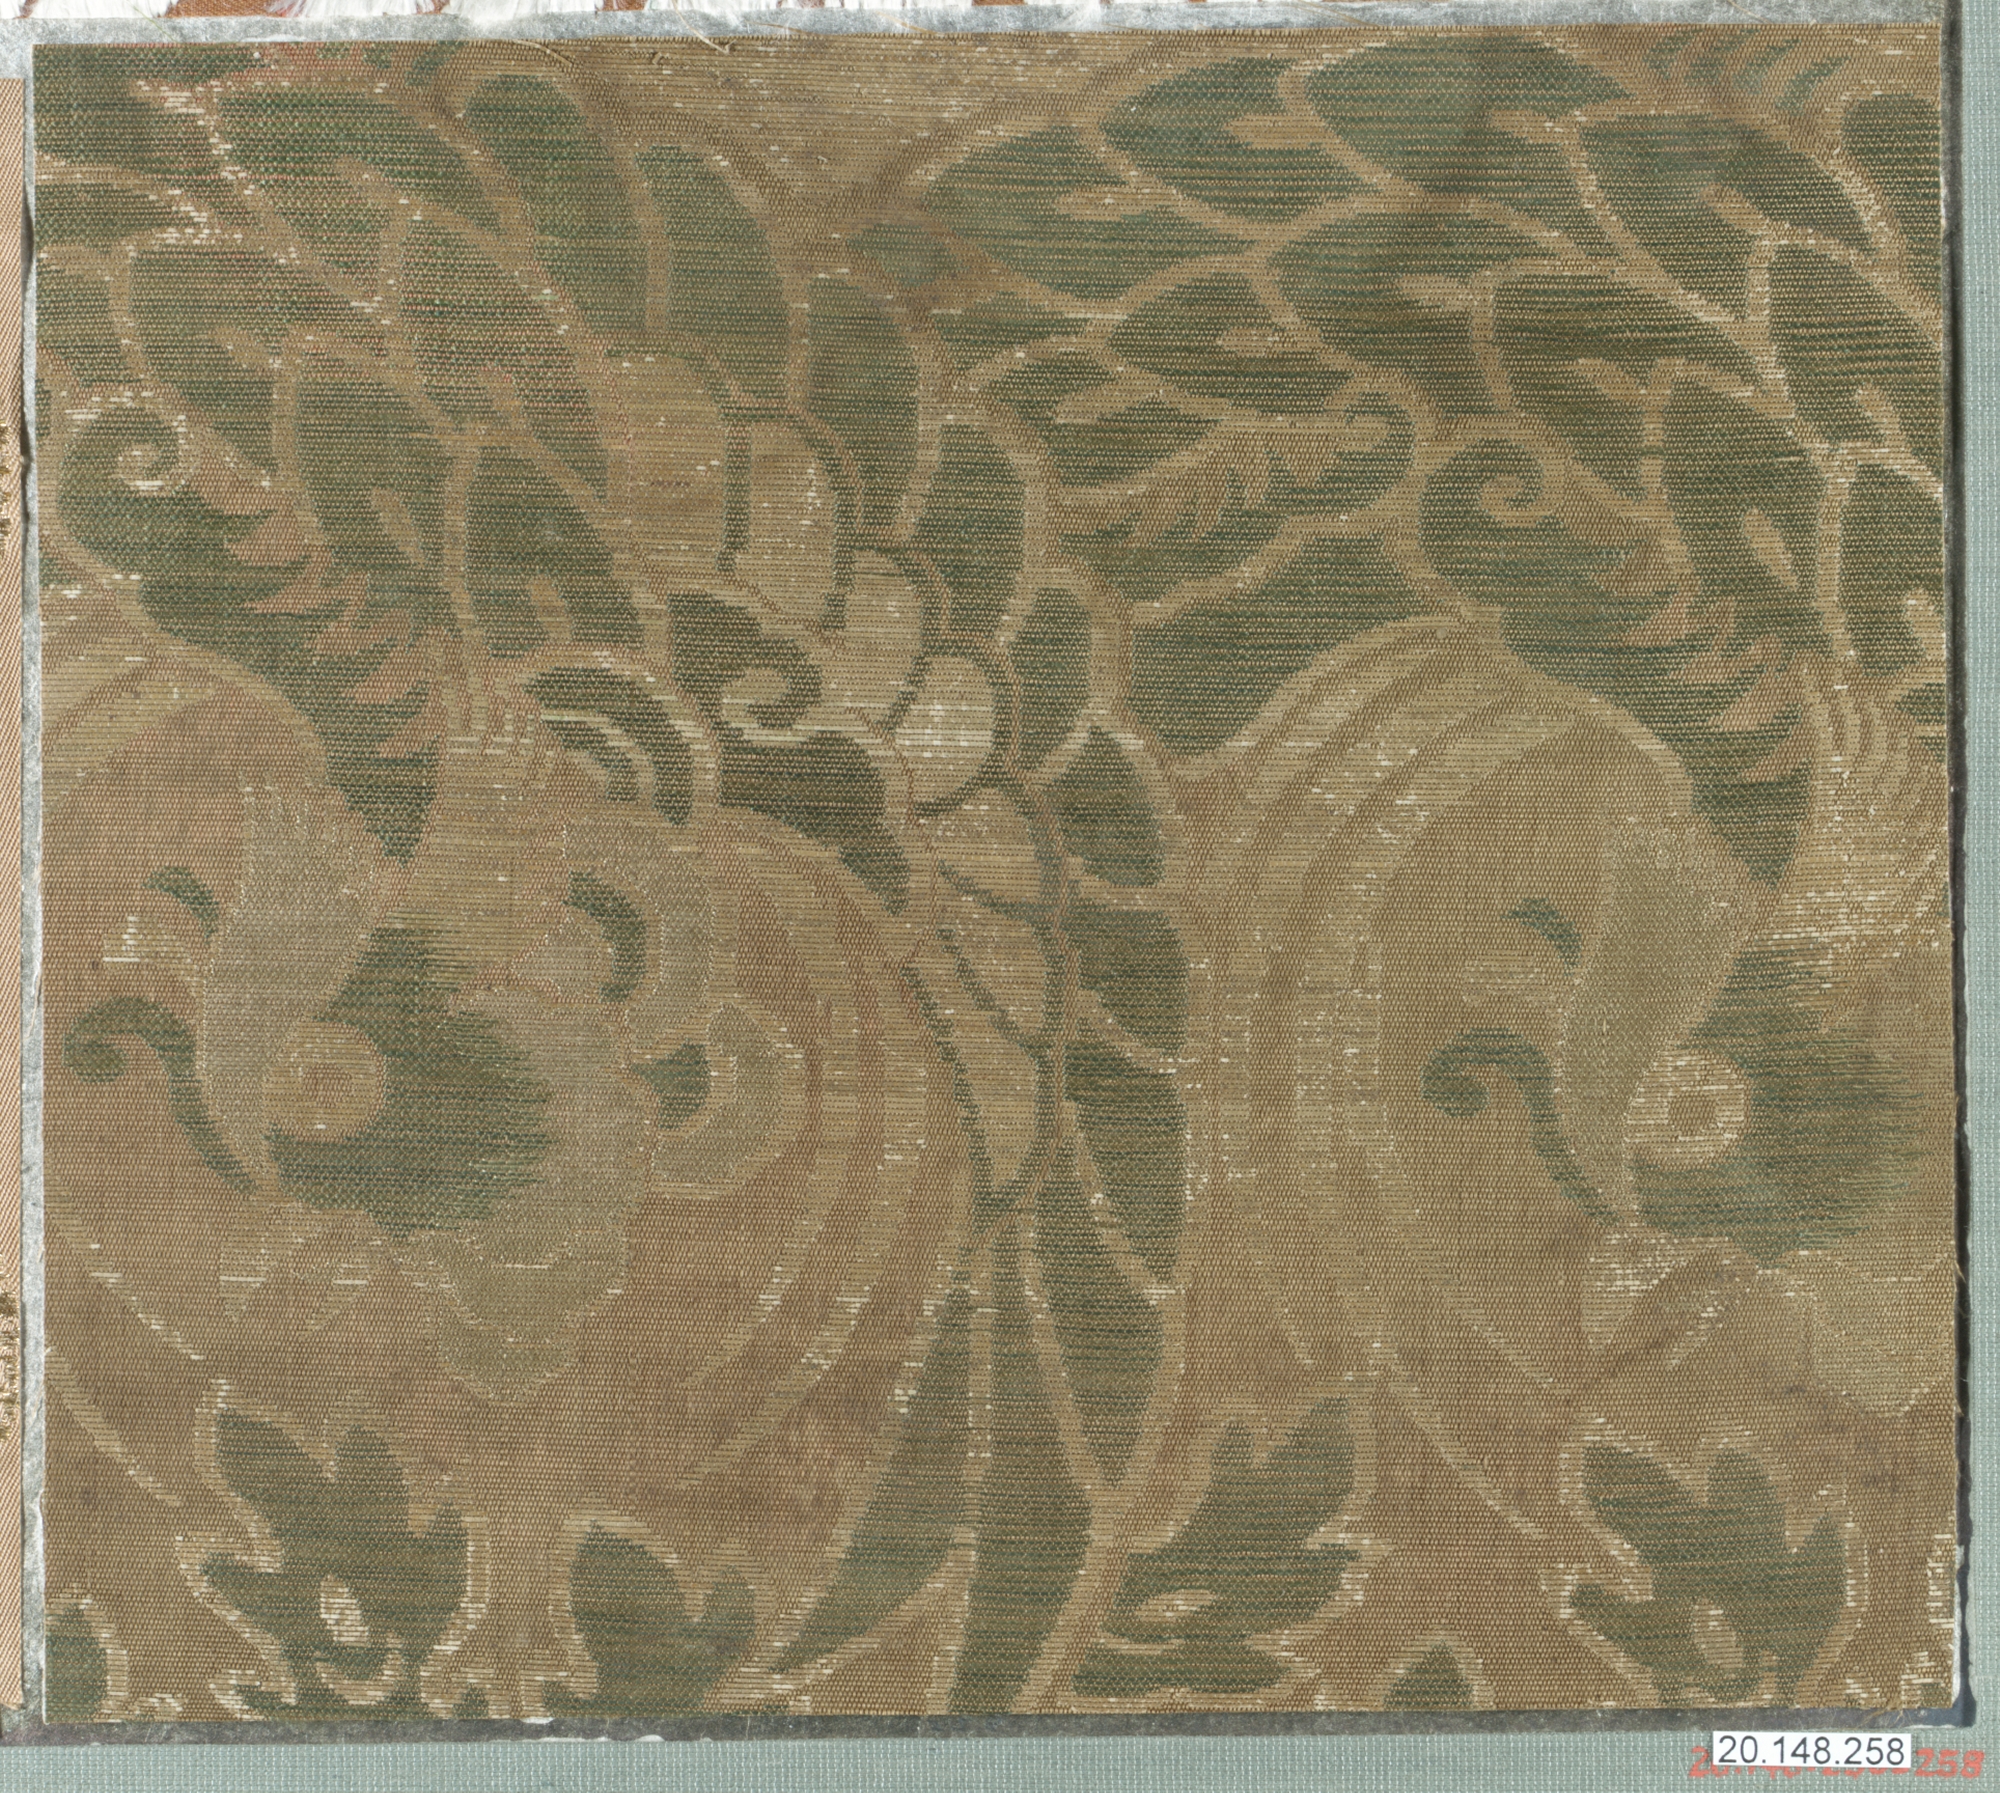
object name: piece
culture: japanese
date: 1601-1700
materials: silk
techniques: compound weave